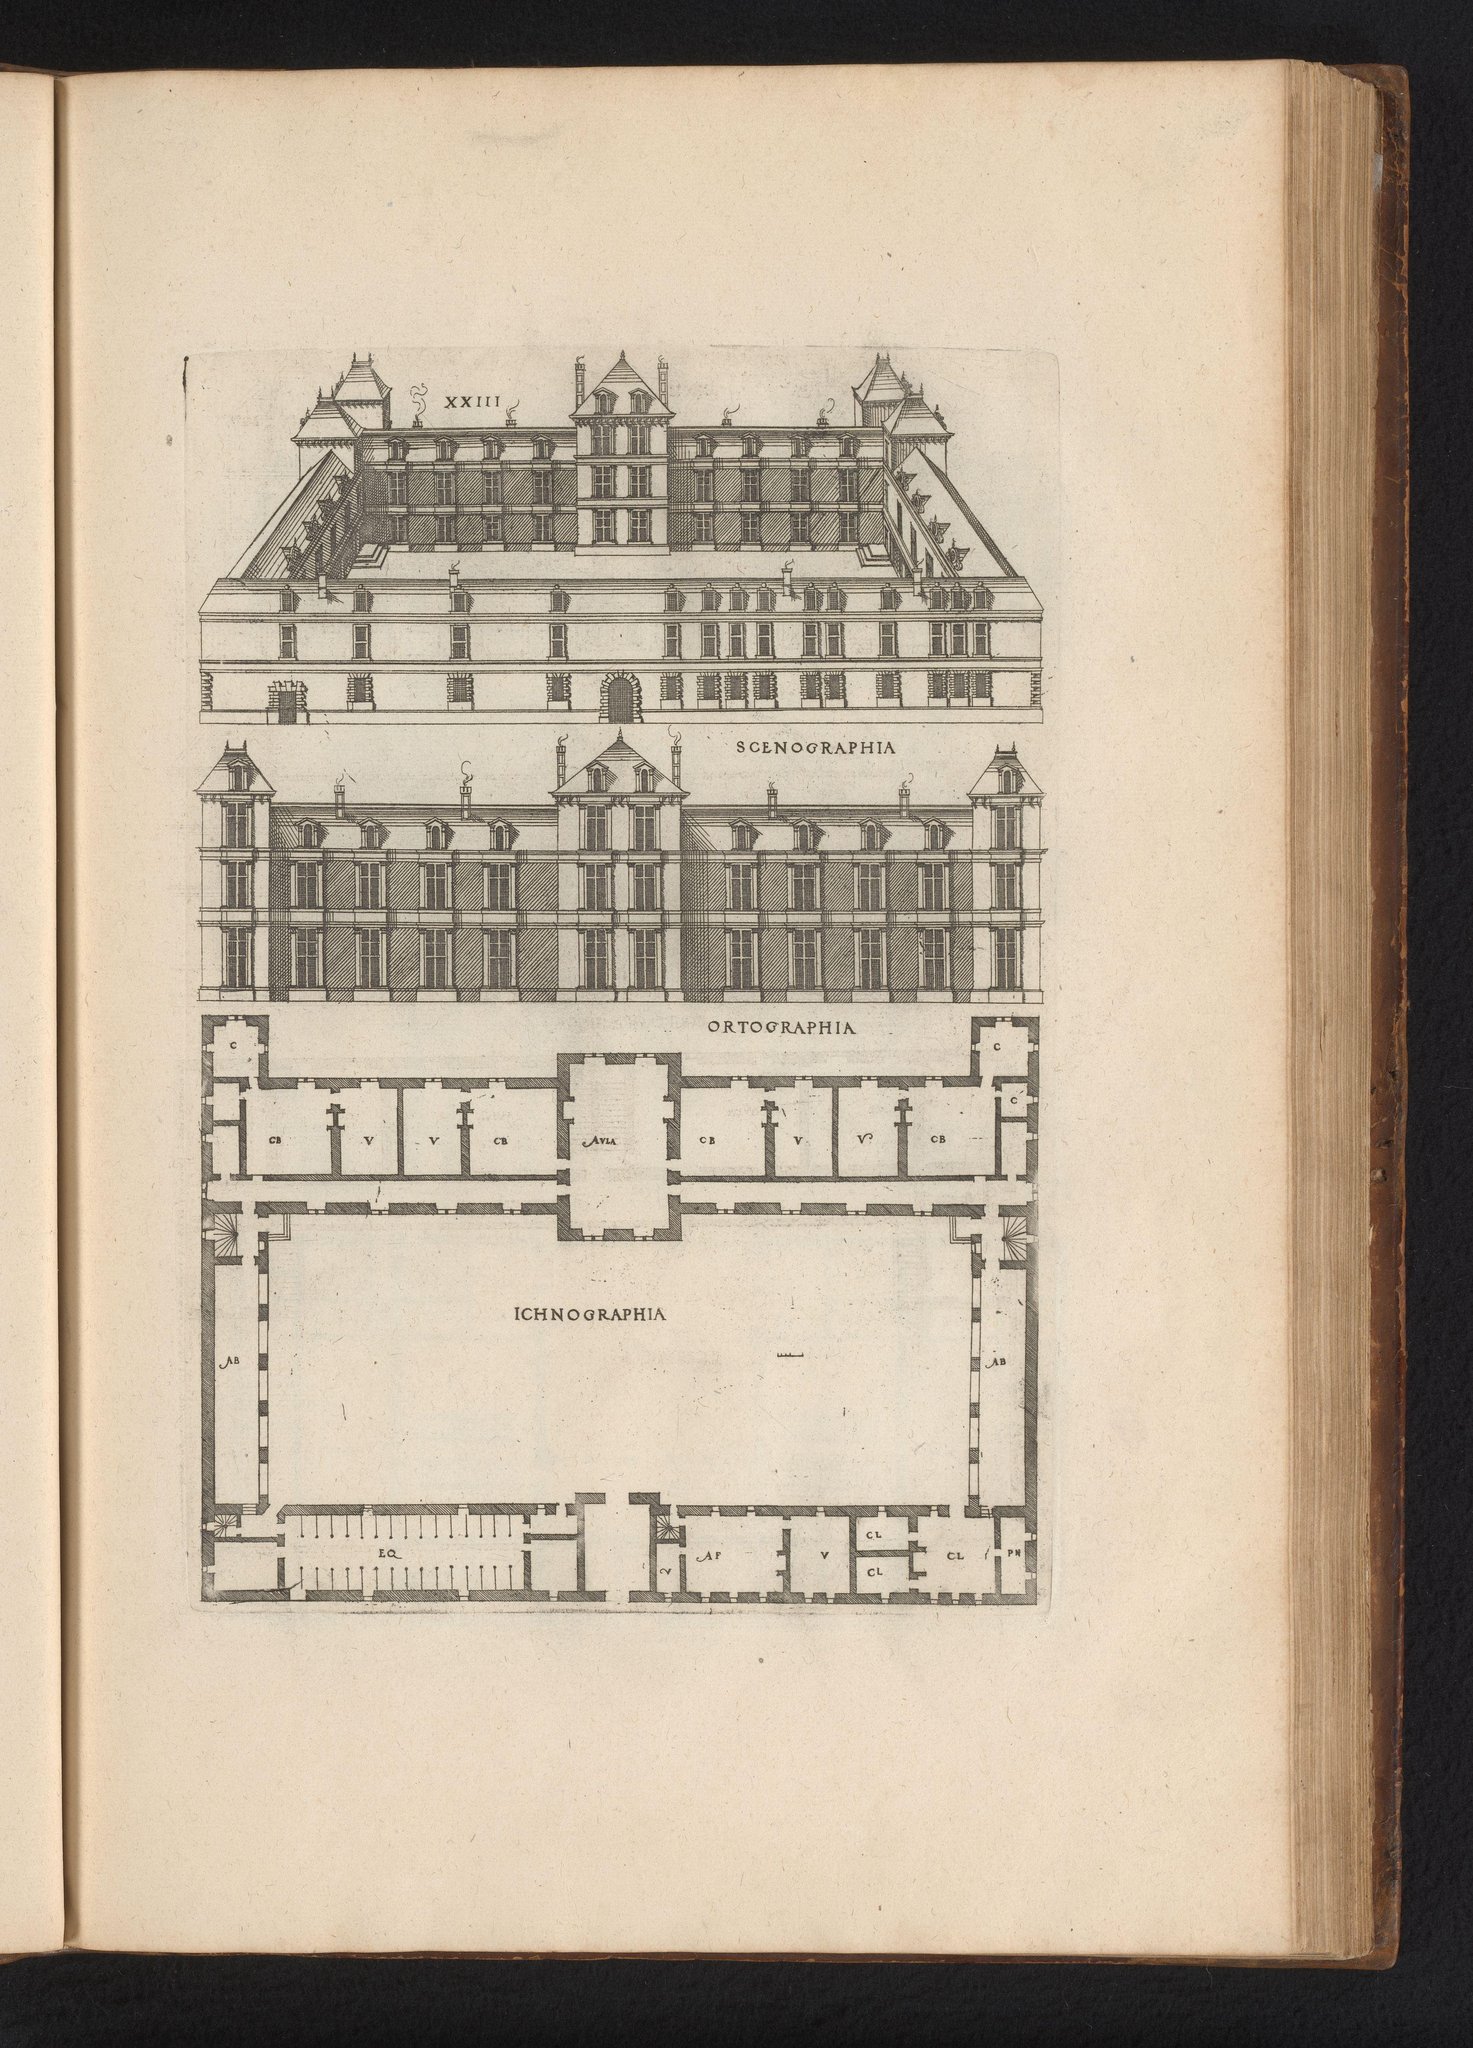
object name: ornament print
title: Vogelvluchtperspectief, voorgevel en plattegrond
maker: jacques androuet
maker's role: draughtsman, print maker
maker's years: 1515-1584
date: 1559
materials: paper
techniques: etching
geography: paris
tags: façade (of house or building), plan ~ architecture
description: Vogelvluchtperspectief, voorgevel en plattegrond. Aanzicht en plattegrond van architectuur. Genummerd: XXIII. Onderdeel van 'De architectura Iacobi Androuetii du Cerceau' (1559): 69 etsen met 171 voorstellingen van architectuur en ornamentiek.